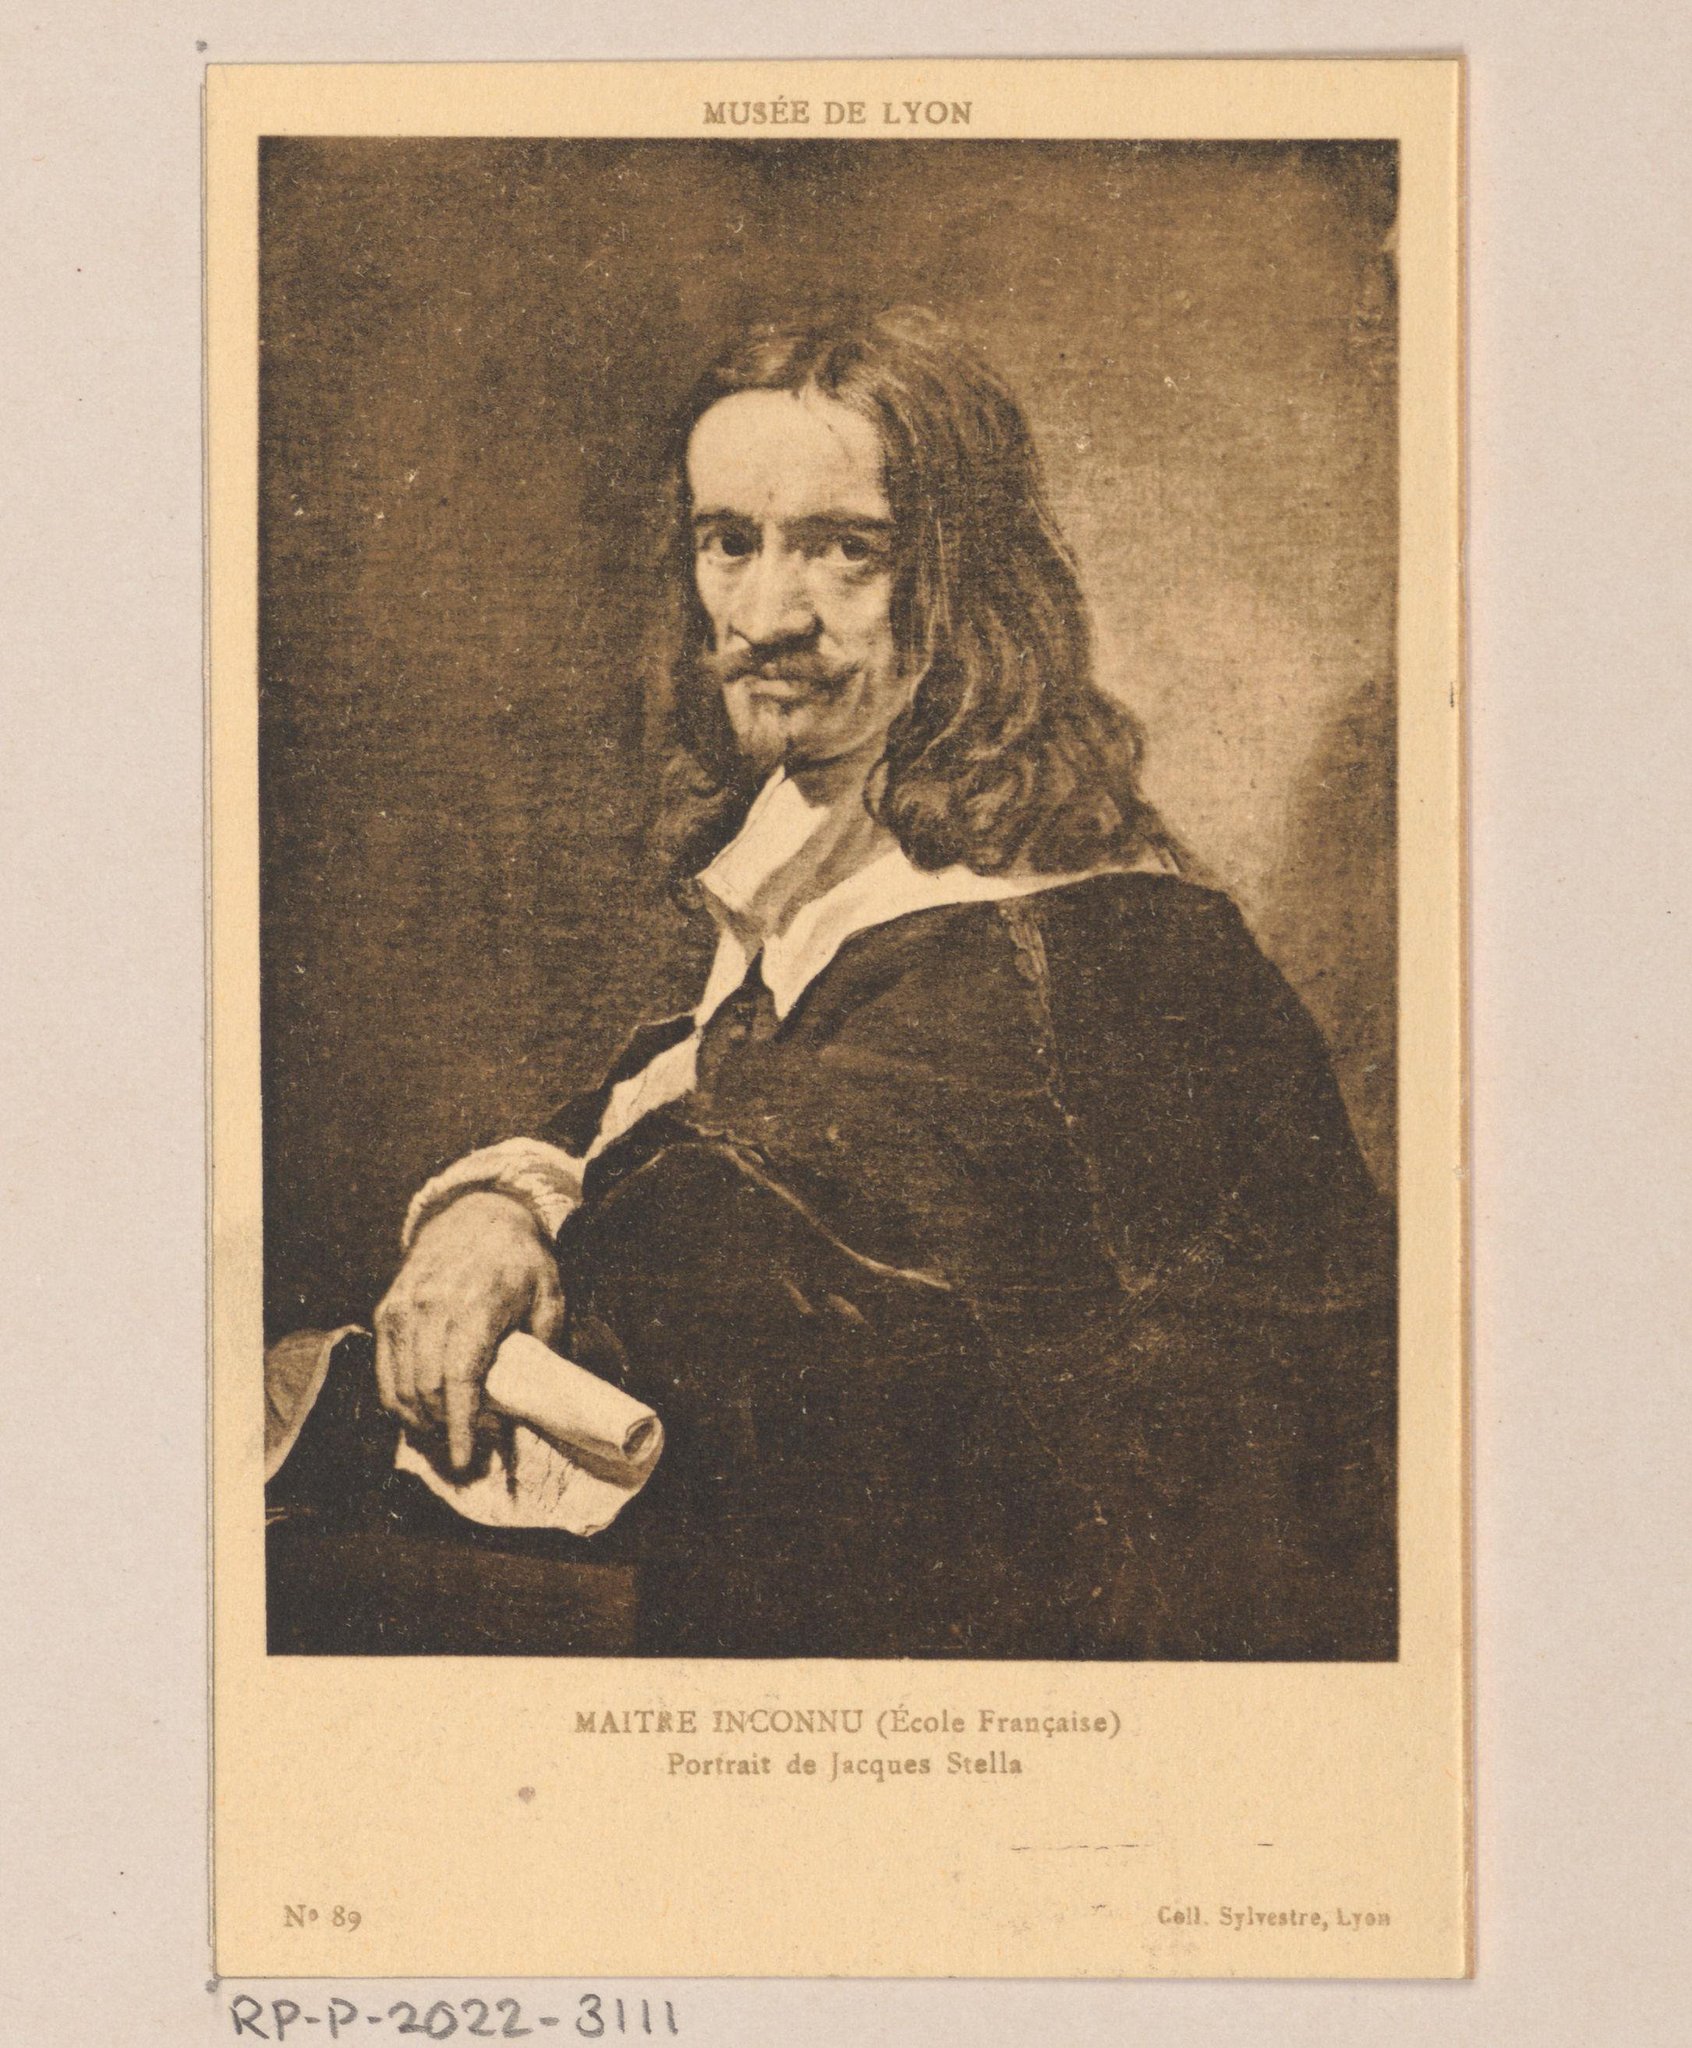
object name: photomechanical print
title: Portret van Jacques Stella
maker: Anonymous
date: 1875-1930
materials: paper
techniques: photograph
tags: lyon, paris, print maker, draughtsman, jacques stella, historical persons, portrait, self-portrait of artist